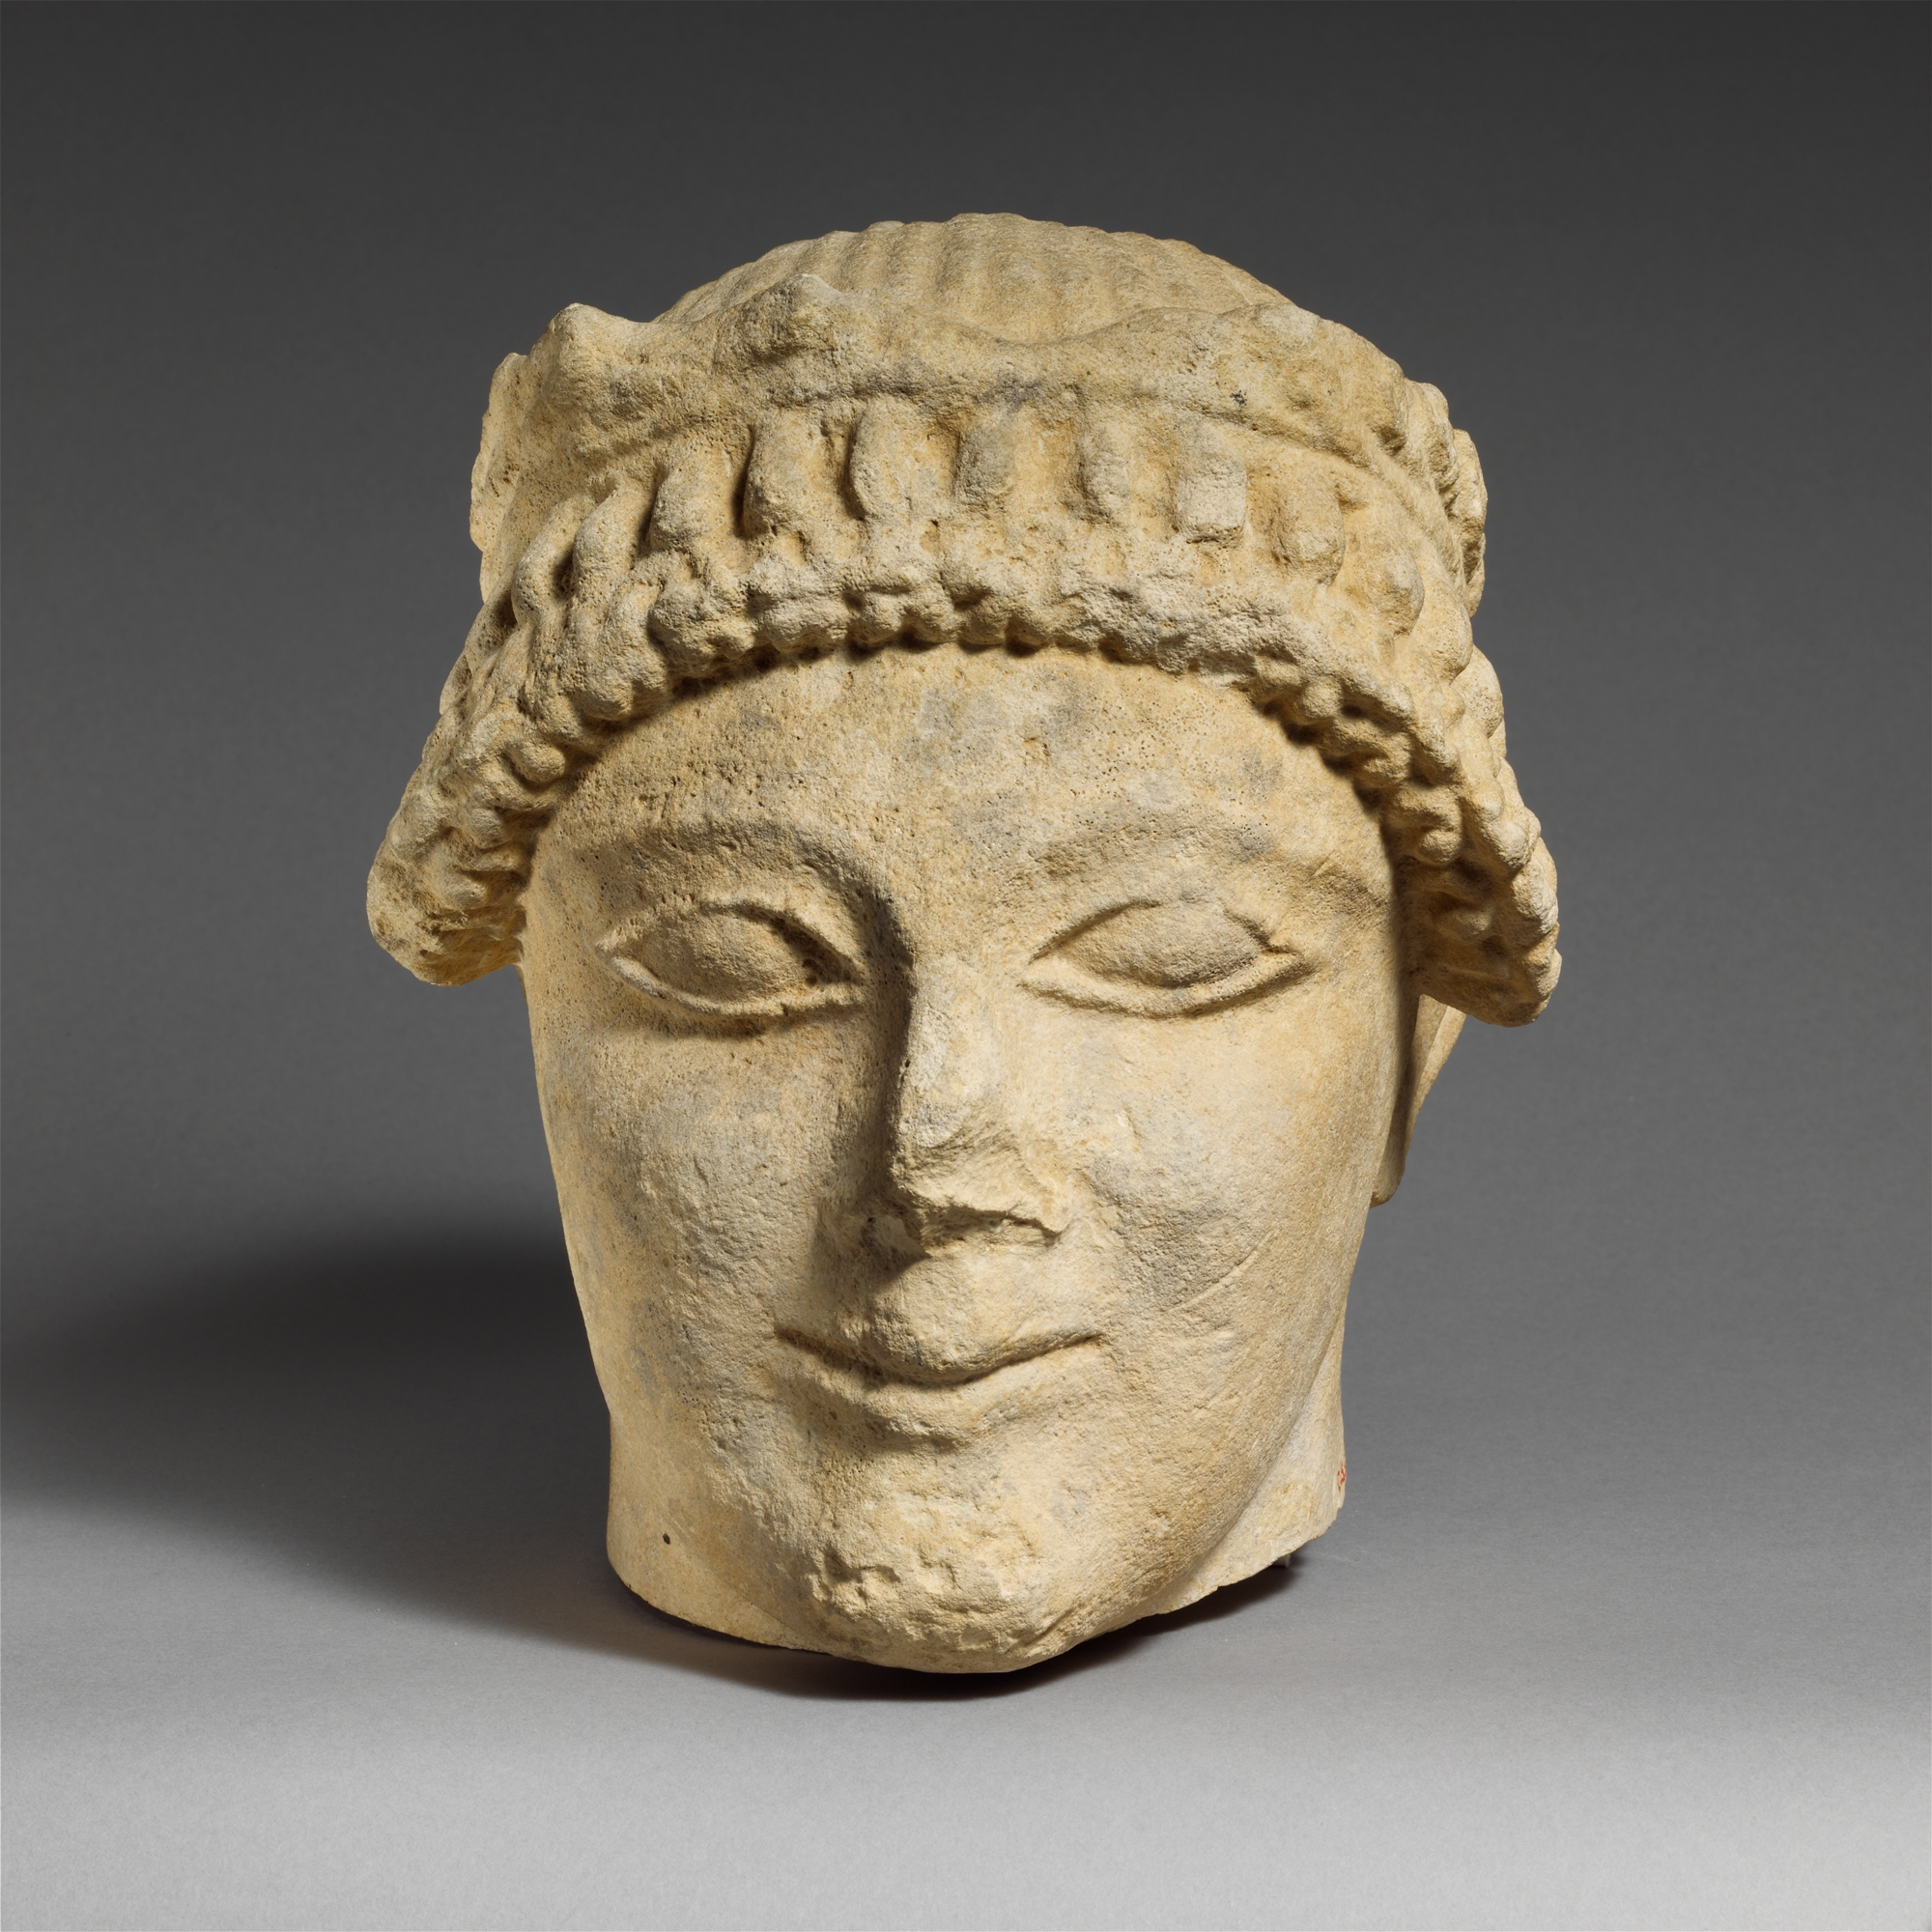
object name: head of a man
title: Limestone head of a beardless male votary with a wreath of leaves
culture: cypriot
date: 475-451 BCE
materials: limestone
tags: heads,men,wreaths